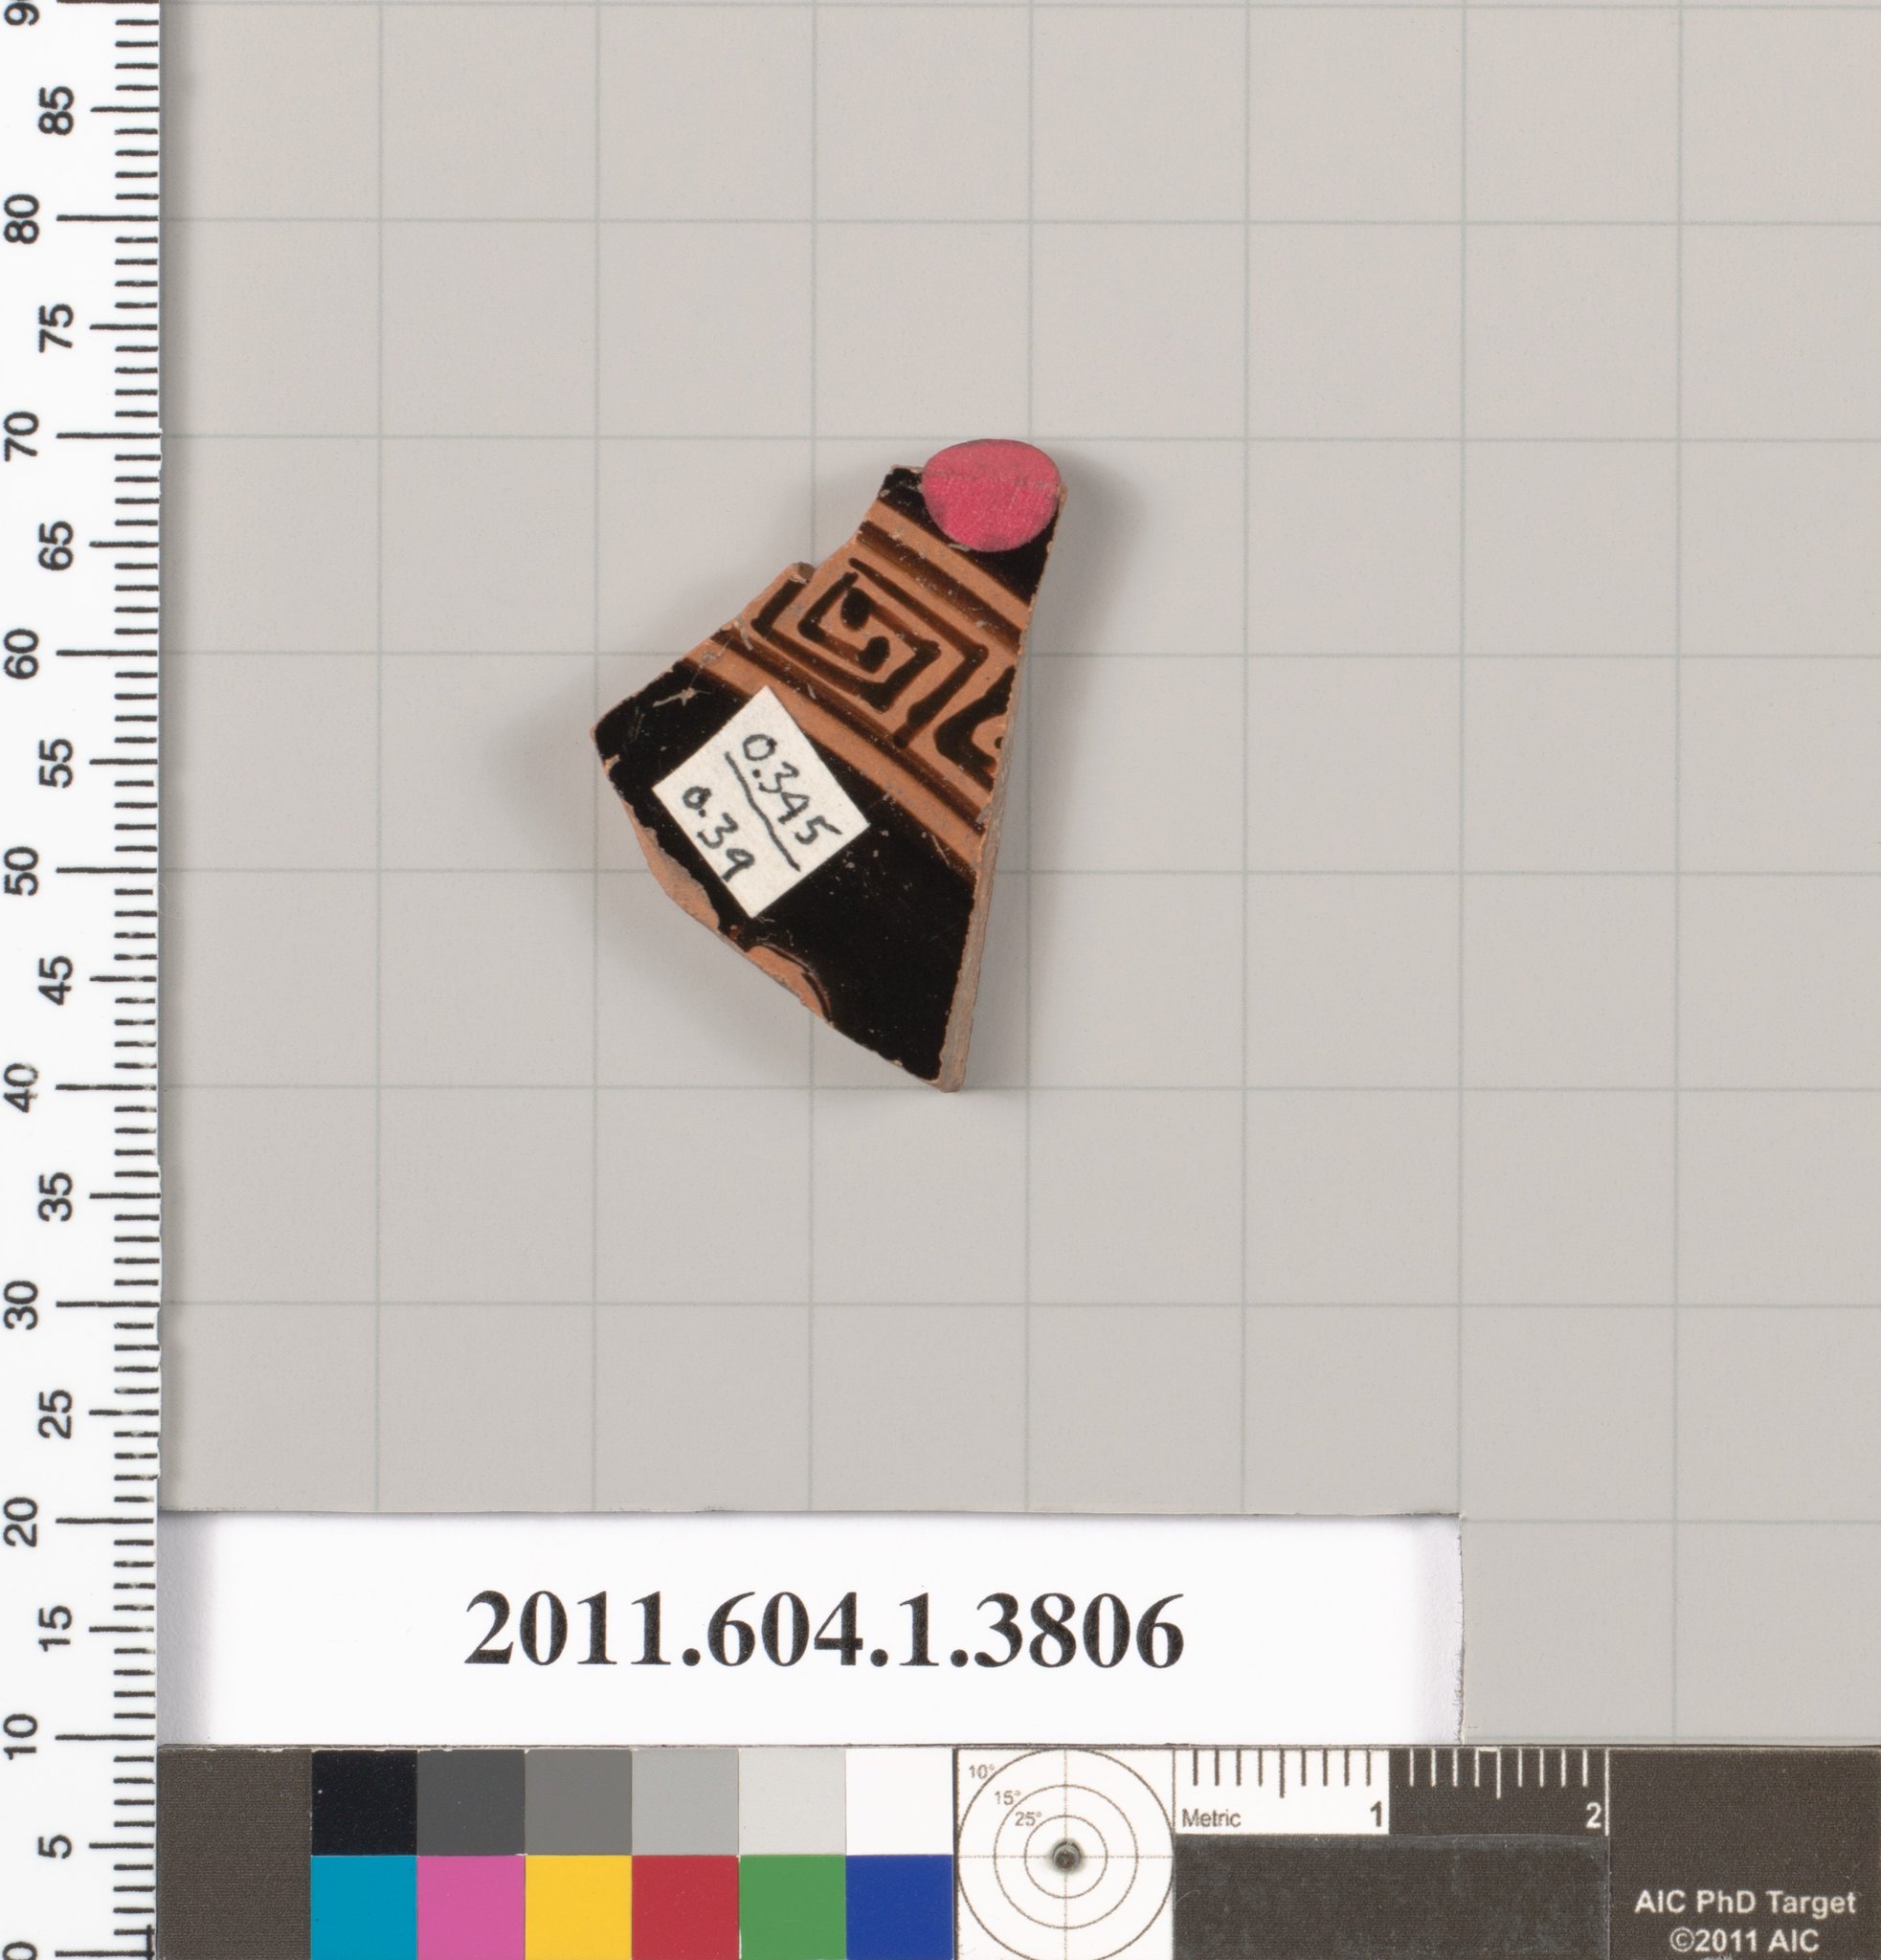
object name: kylix fragment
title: Terracotta fragment of a kylix (drinking cup)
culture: greek, attic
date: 475-451 BCE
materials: terracotta